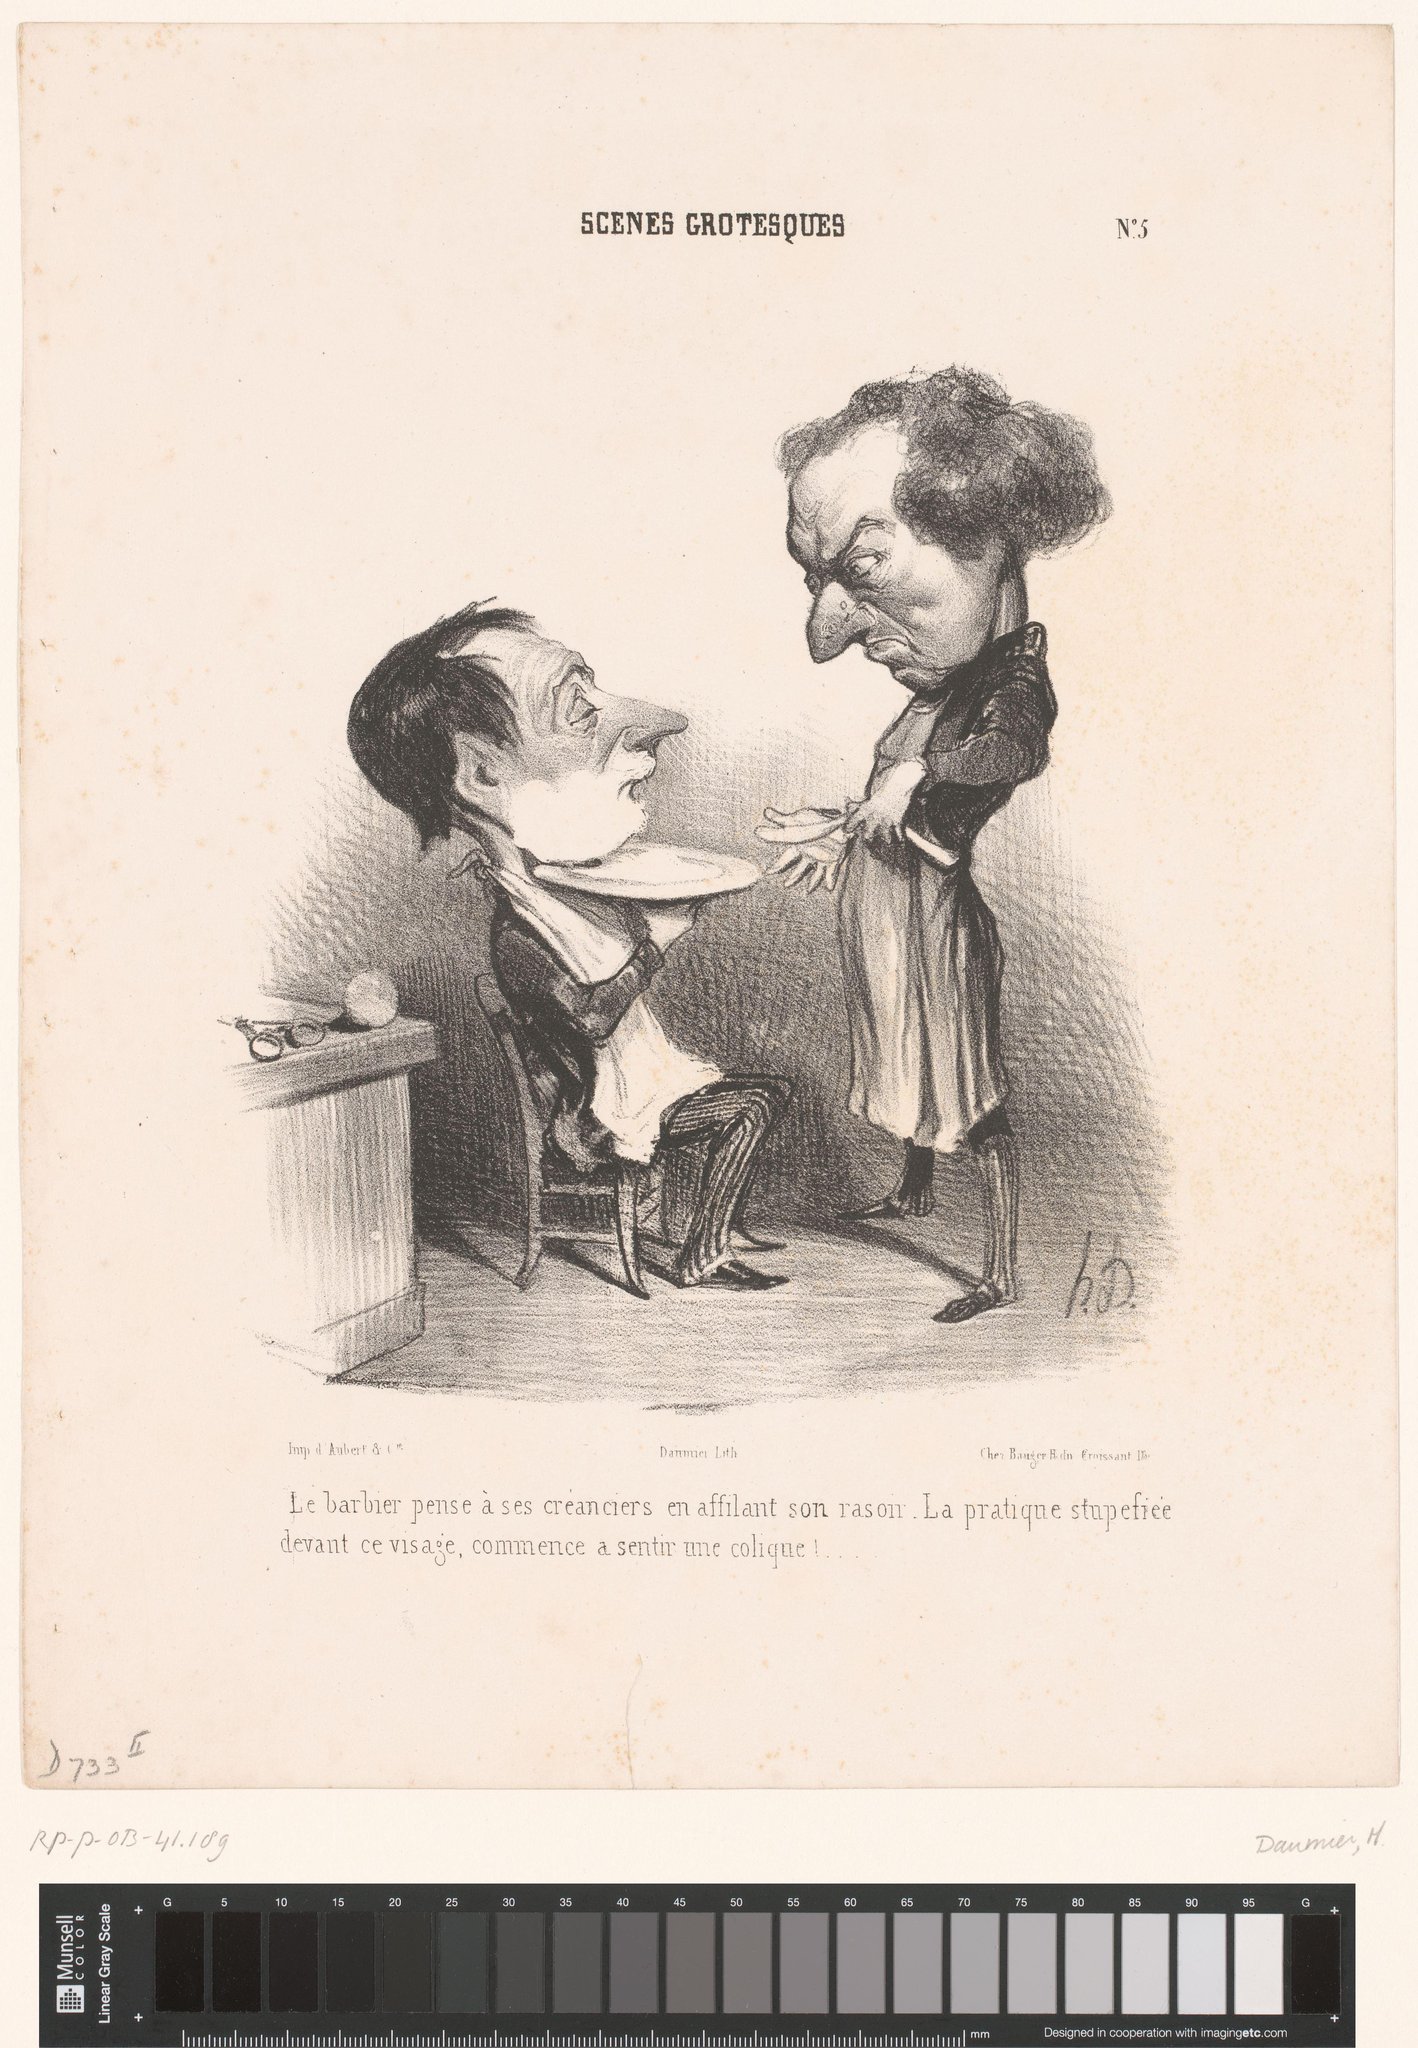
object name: cartoon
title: Scènes grotesques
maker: honoré daumier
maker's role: draughtsman, painter, print maker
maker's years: 1808-1879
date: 1839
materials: paper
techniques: lithograph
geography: paris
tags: caricatures (human types), shaving, being shaved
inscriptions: collector's mark: Lugt 2228a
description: Prent gebruikt voor: Le Charivari, 12 oktober 1839.